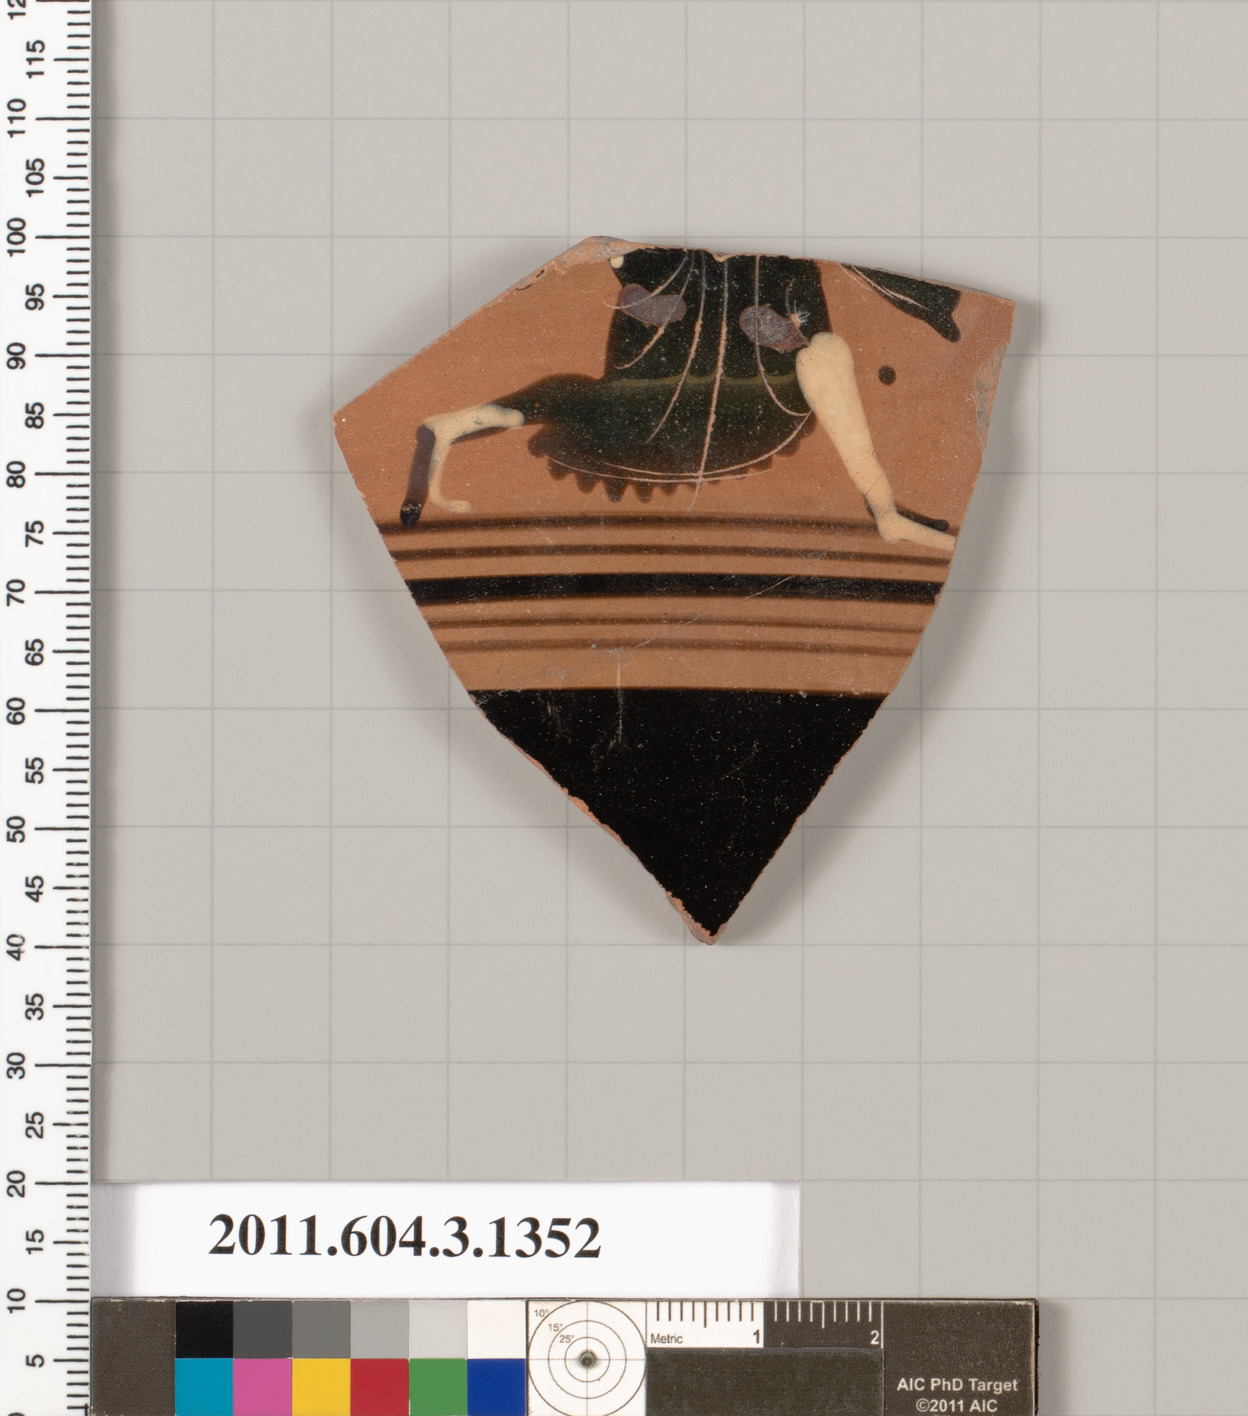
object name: skyphos fragment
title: Terracotta fragment of a skyphos (deep drinking cup)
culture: greek, attic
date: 500-468 BCE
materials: terracotta